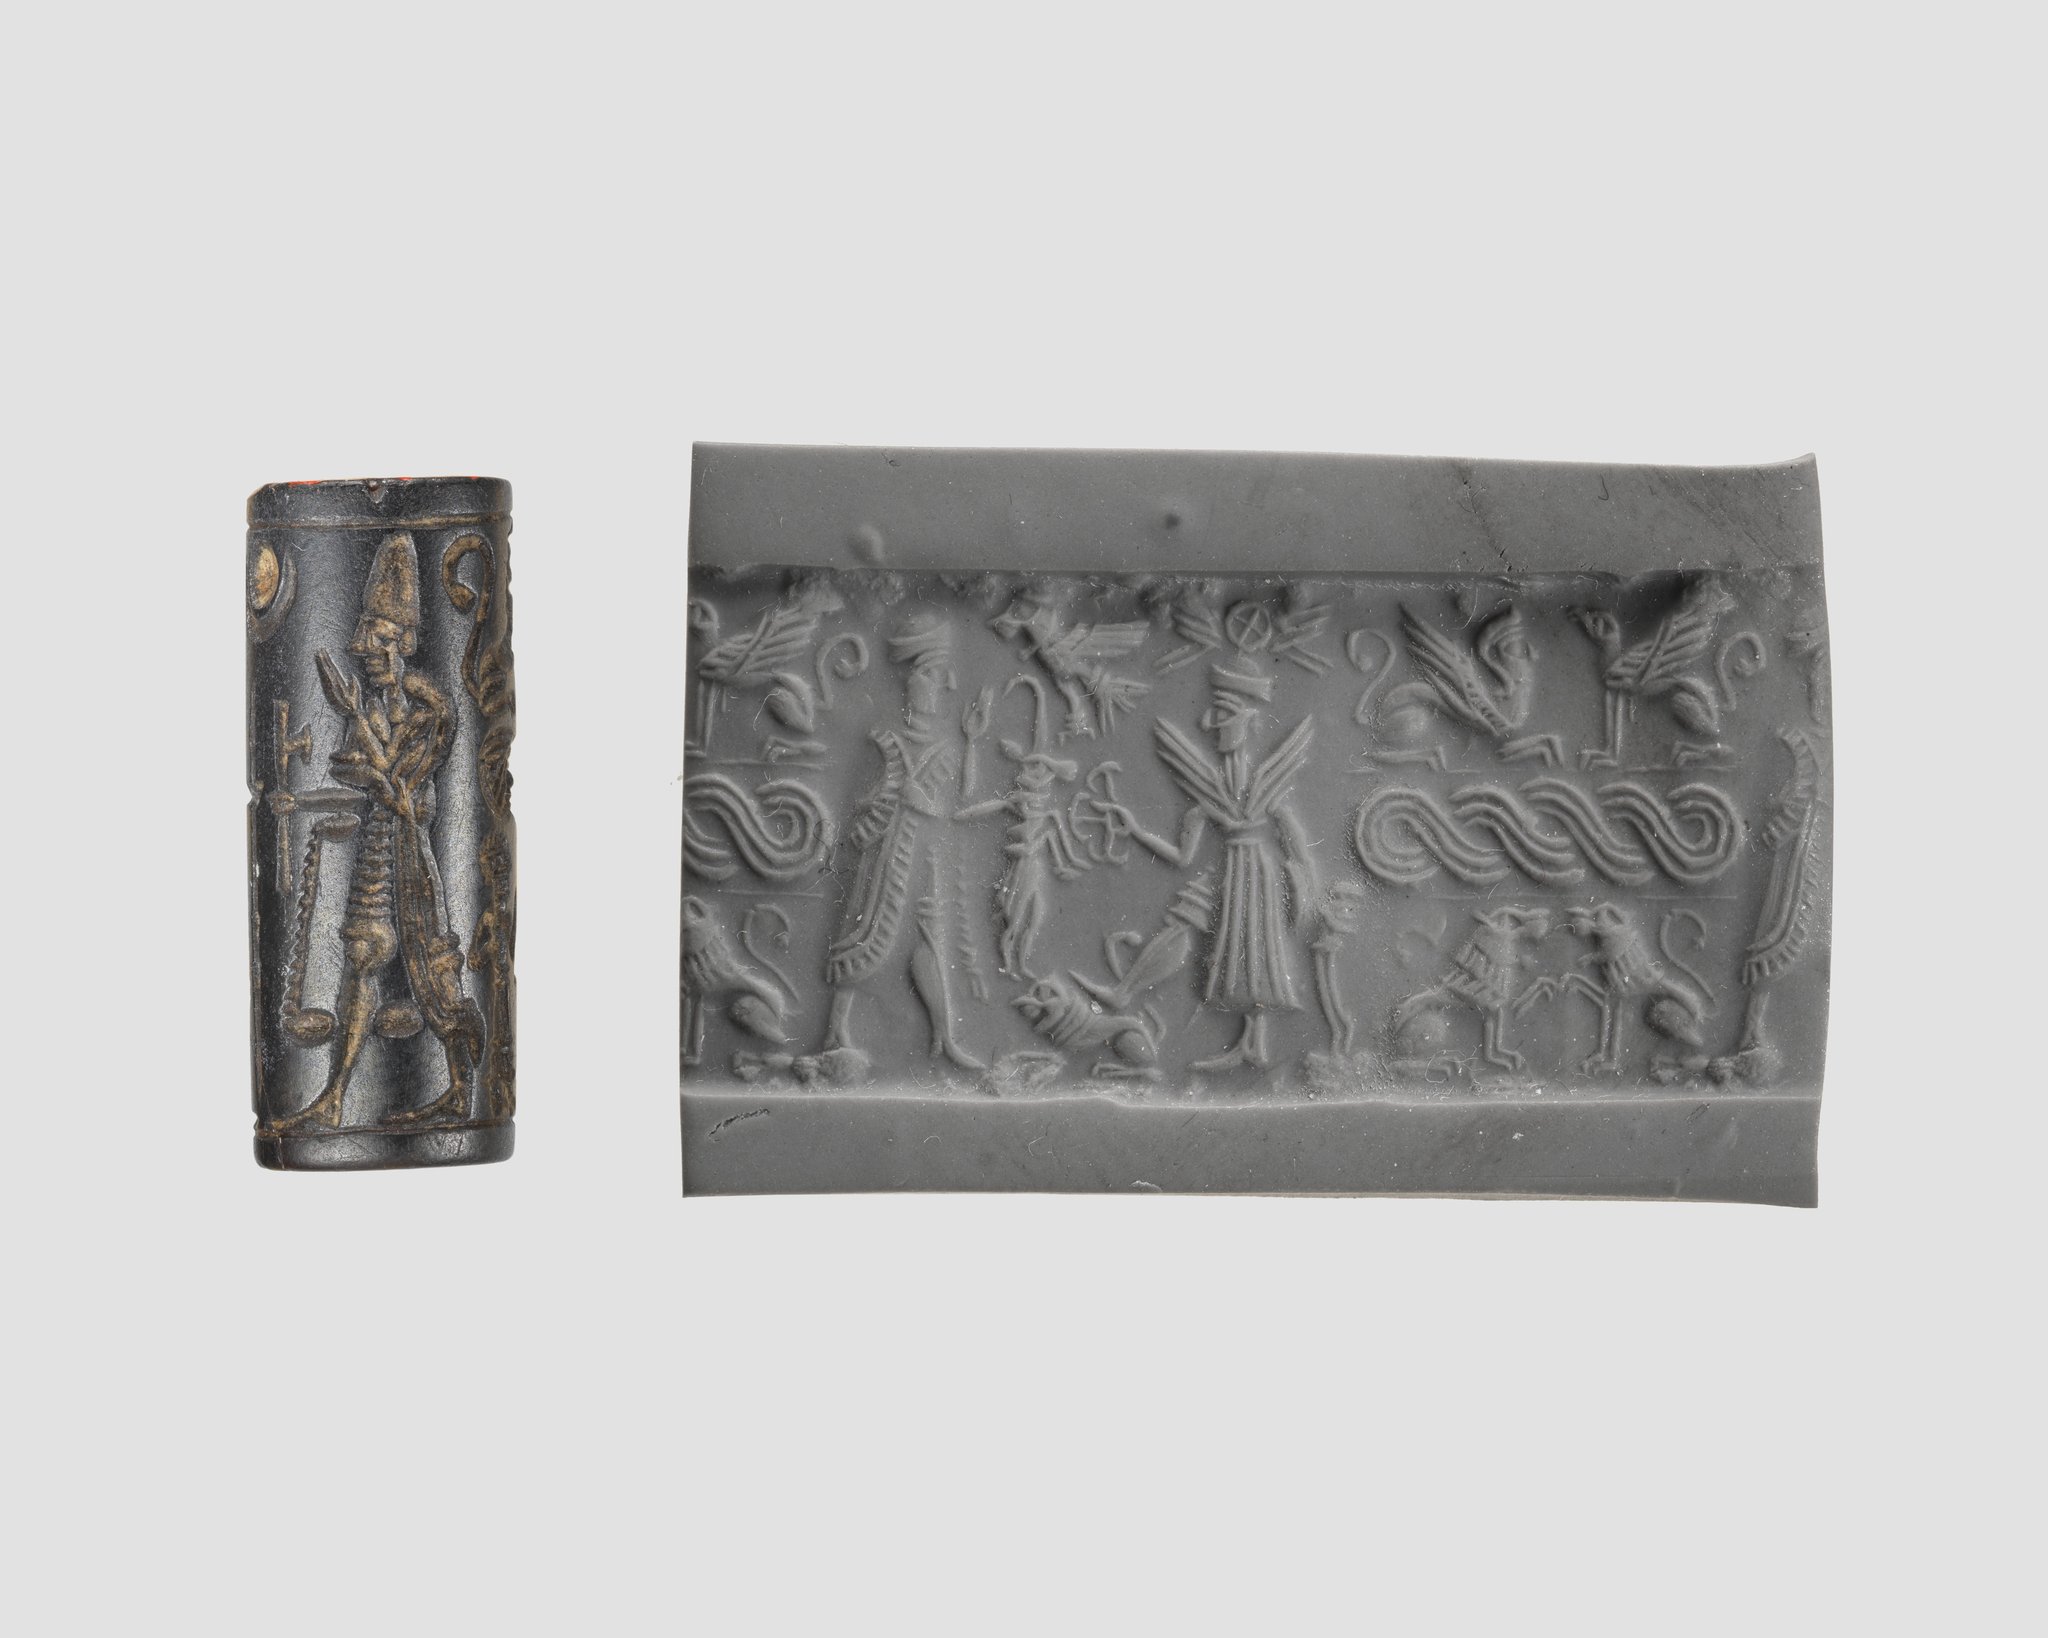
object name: cylinder seal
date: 1720-1650 BCE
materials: mineral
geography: syria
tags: lions